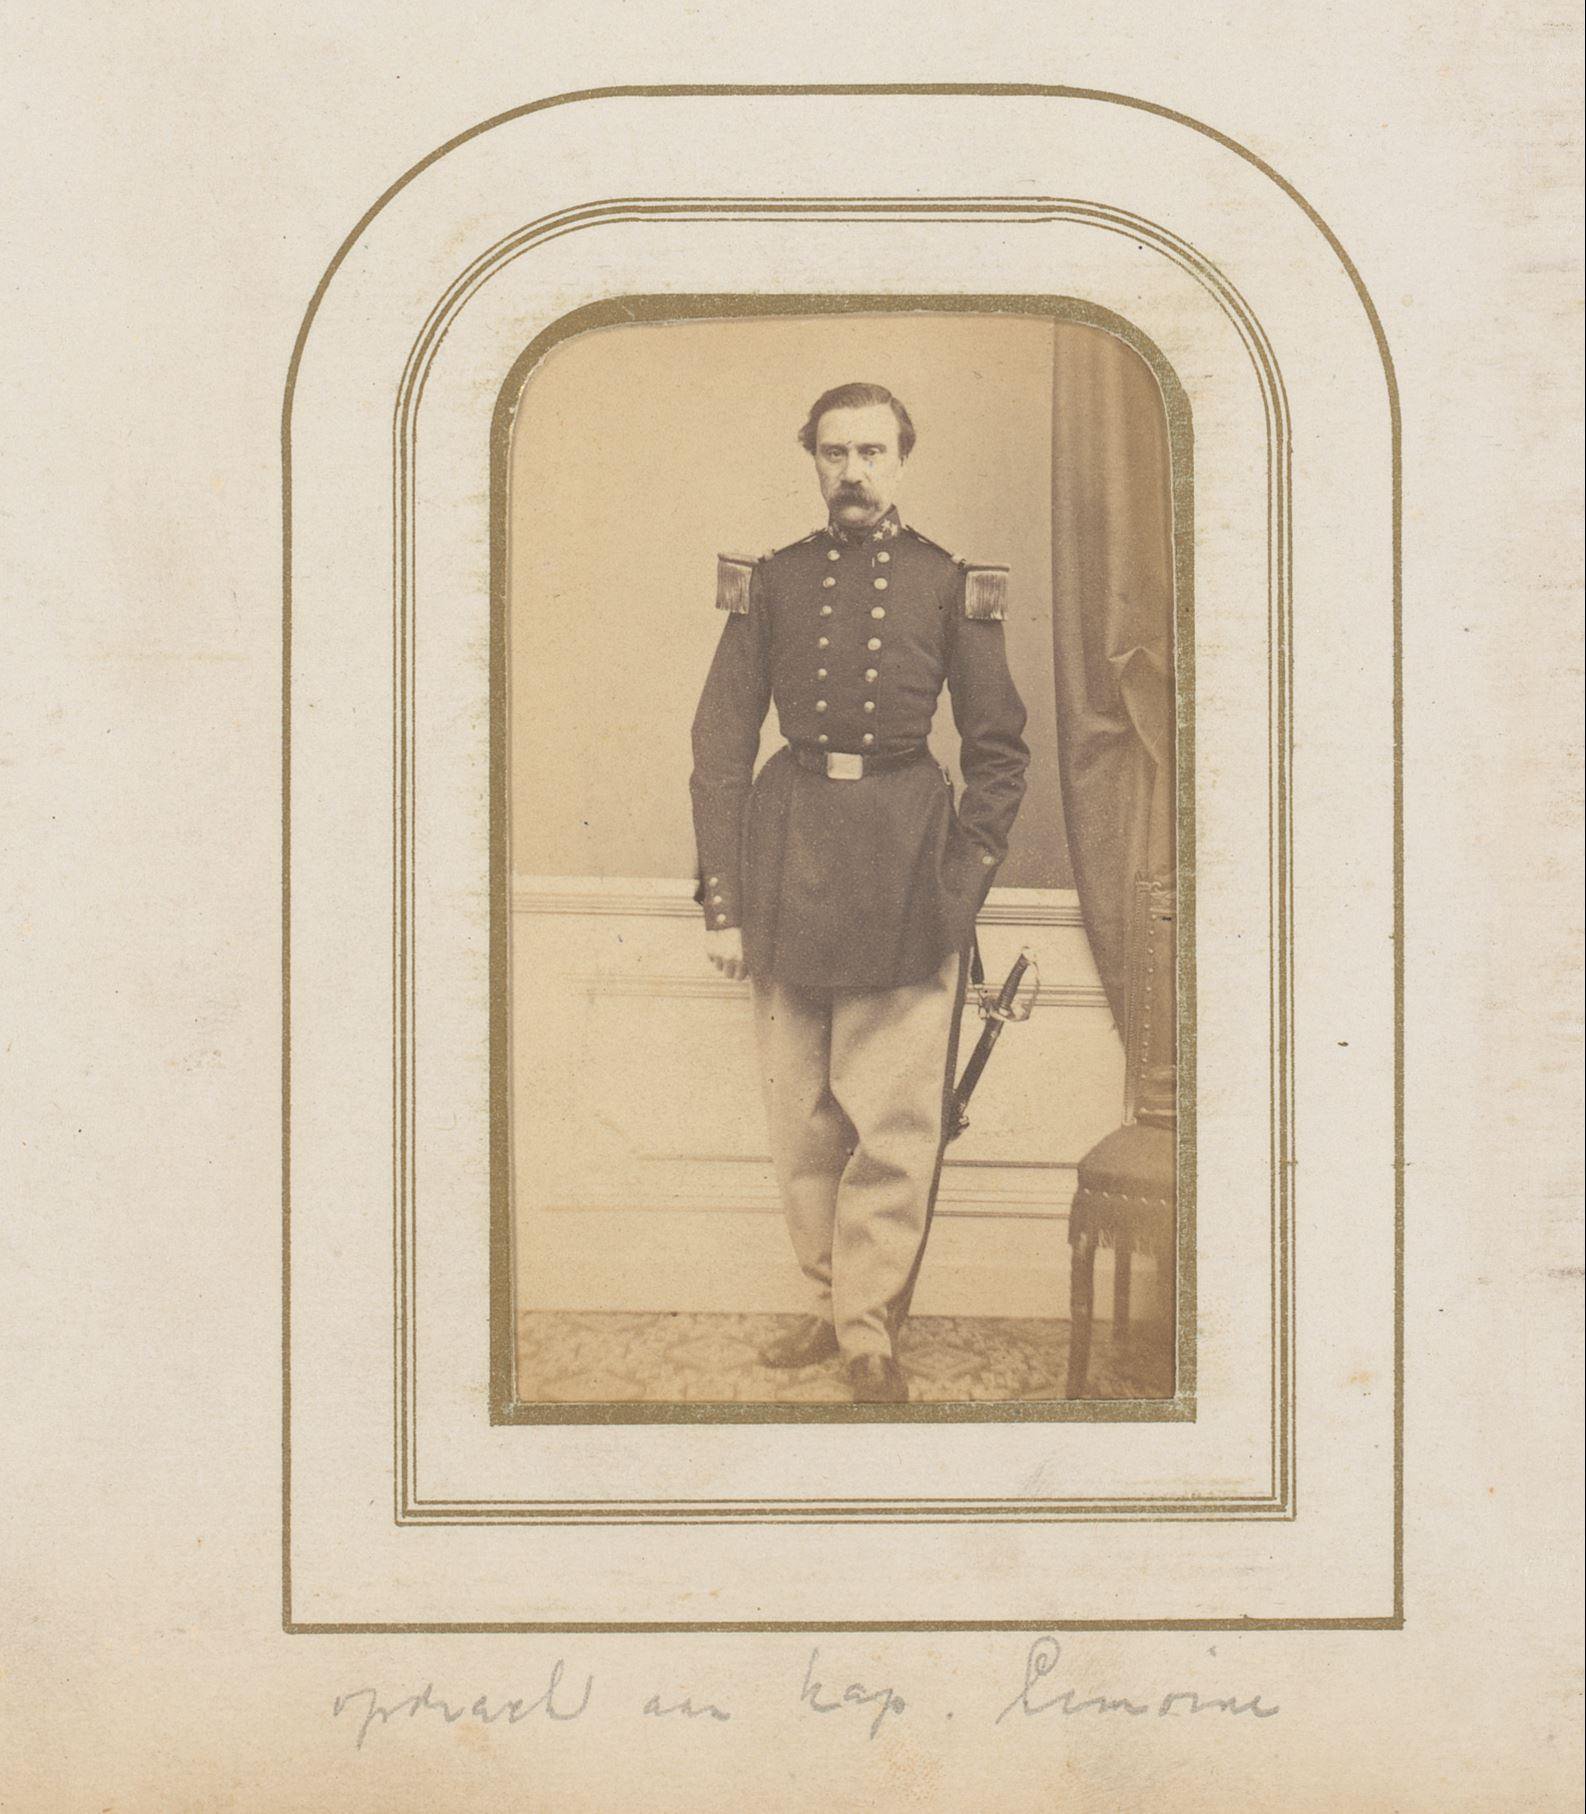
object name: carte de visite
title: Portret van een staande man in uniform met snor en zwaard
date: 1860-1878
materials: cardboard, photographic support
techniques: albumen print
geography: ghent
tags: historical persons, hacking and thrusting weapons: sword, (military) uniforms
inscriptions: annotation: ‘opdracht aan kap. Lemoine’, annotation: ‘Au camarade Lemoine’, inscription: ‘Roose/ Photographe/ Rue de l'Agneau, No 3/ près de Pont de Fer Marcellis/ Gand’